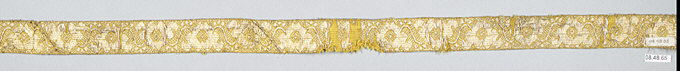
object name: galloon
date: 1600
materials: metal thread, silk